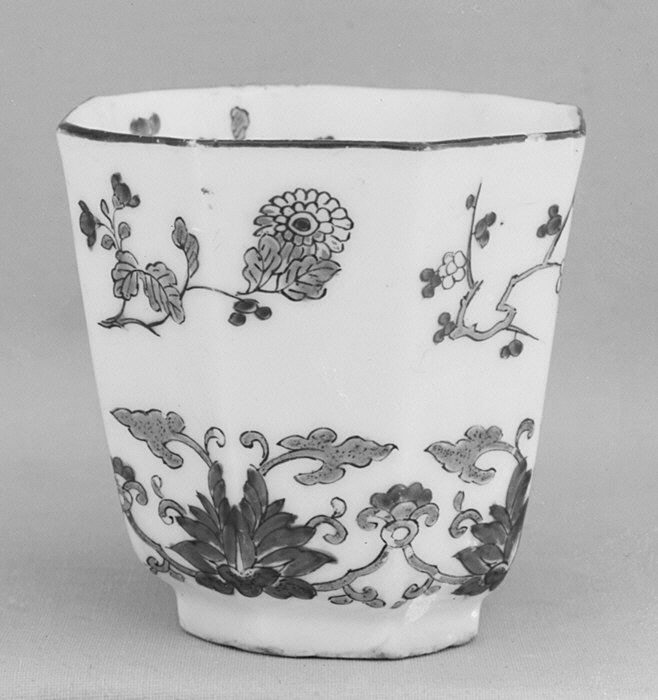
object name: beaker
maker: edmé samson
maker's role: maker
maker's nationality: french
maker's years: 1810-1891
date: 1801-1900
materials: hard paste porcelain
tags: flowers